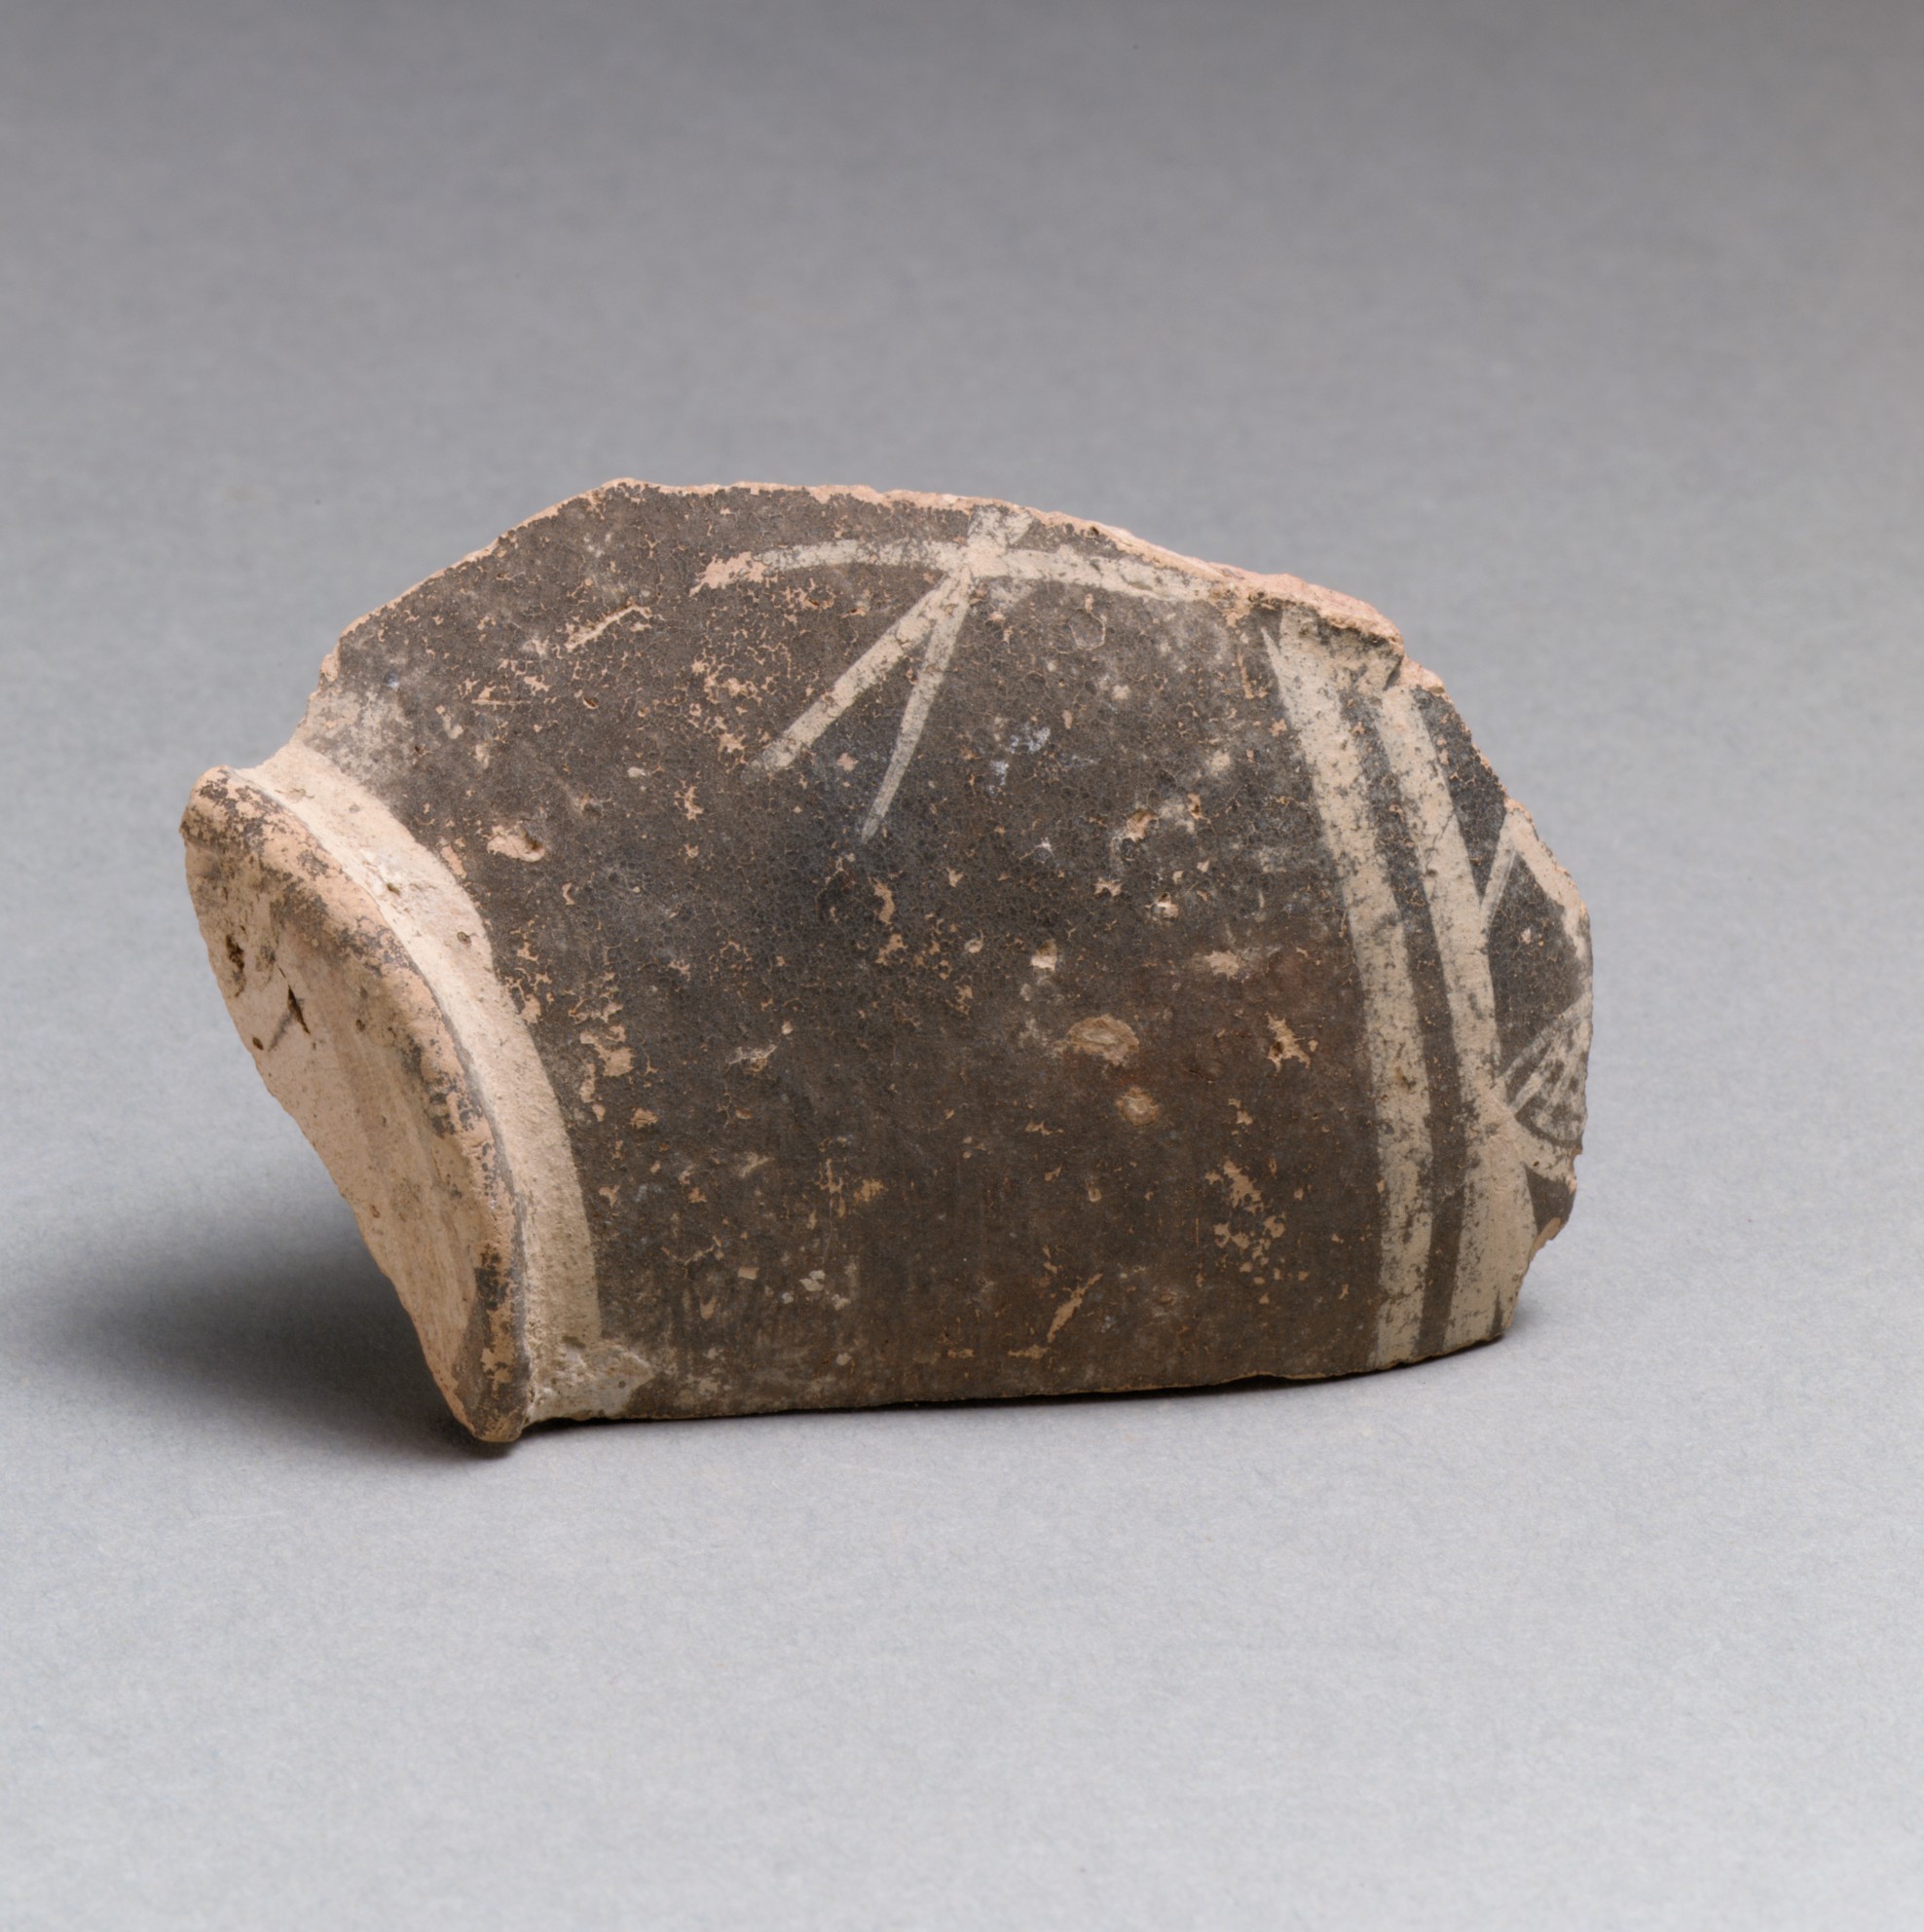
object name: vase fragment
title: Terracotta base of a small vase with linear decoration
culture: minoan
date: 2300-2100 BCE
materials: terracotta